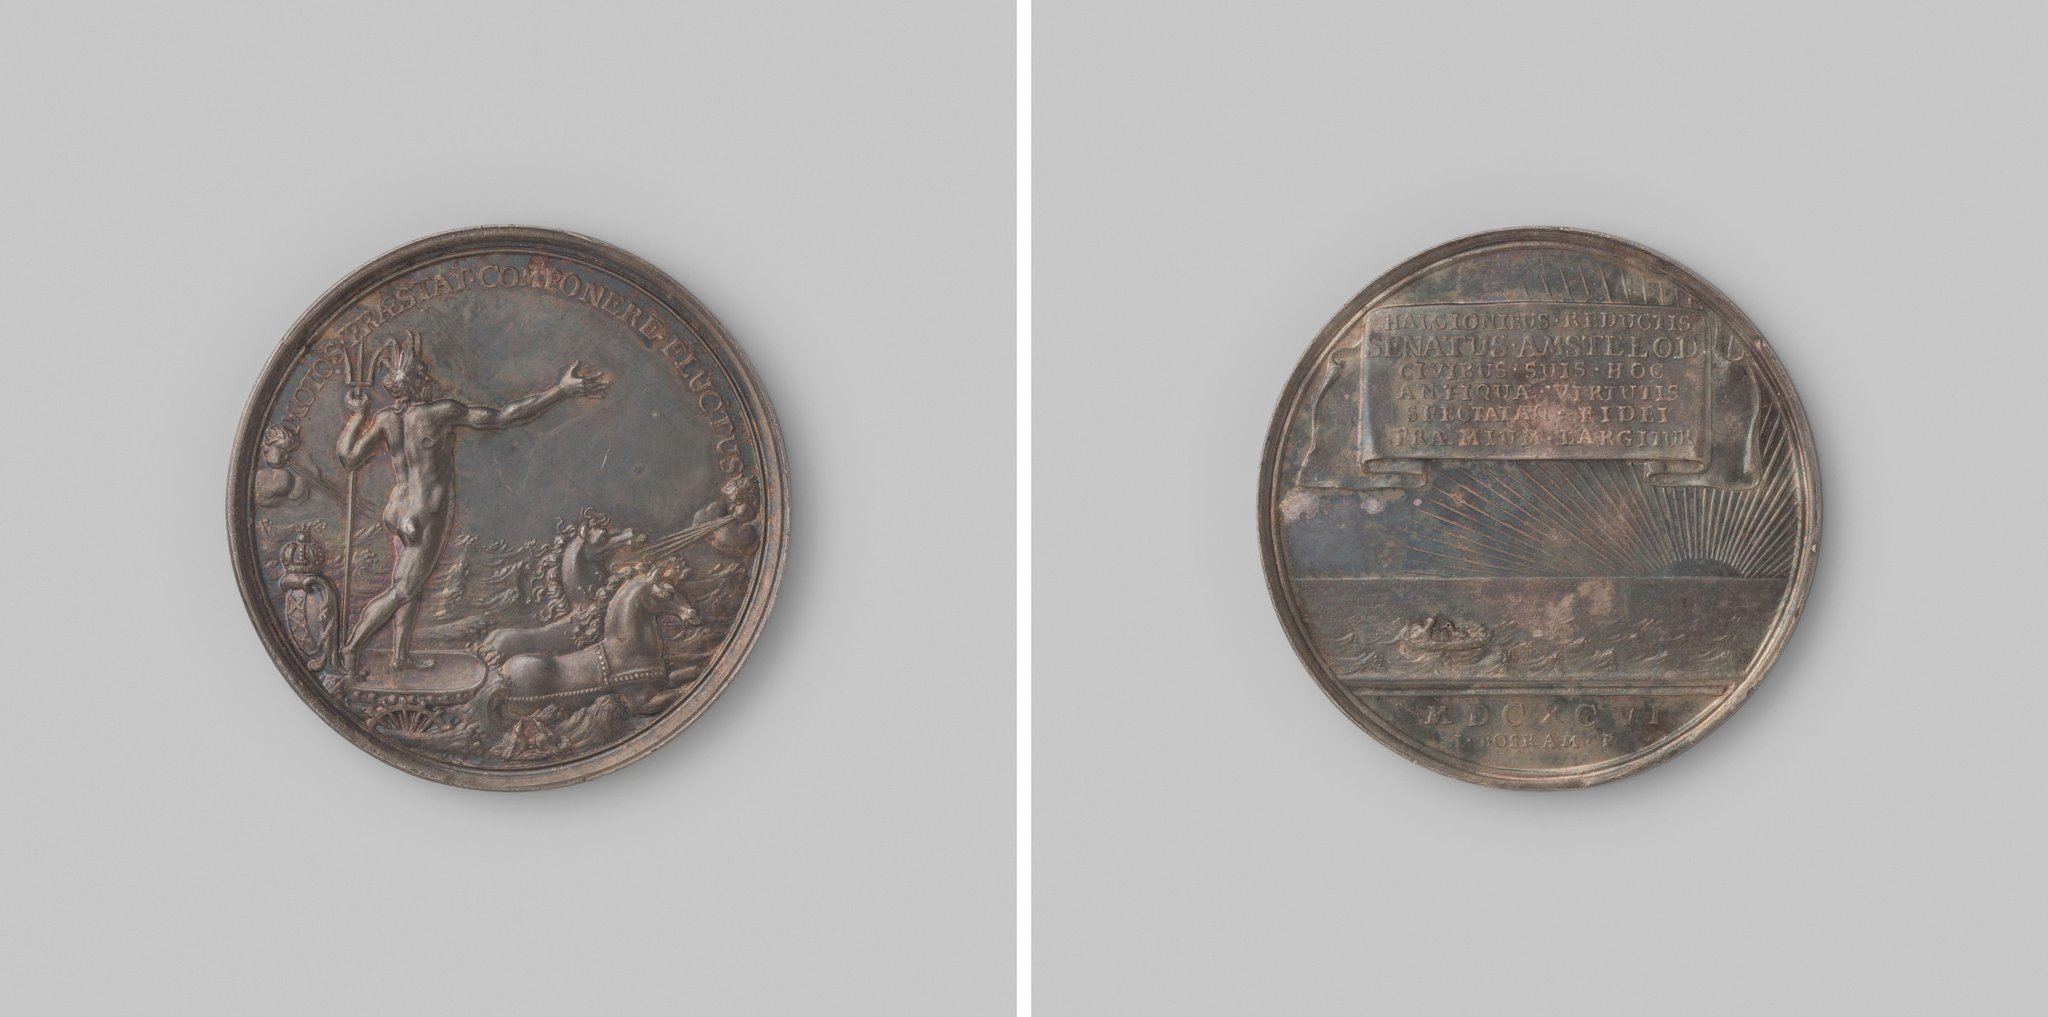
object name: history medal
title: Op de demping van het aansprekersoproer te Amsterdam naar aanleiding van de keur op het begraven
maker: i. roskam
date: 1696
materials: silver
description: Zilveren penning, 3e grootte. Door de magistraat uitgereikt aan de schutters. Voorzijde: Neptunus bestraft de winden staande op zijn wagen met het stadswapen van Amsterdam met keizerskroon. Op de voorgrond twee vogels die uit het nest vallen. Omschrift: MOTOS PRAESTAT COMPONERE FLVCTVS (Beter om de in beroering gebrachte golven te bedaren). Keerzijde: twee vogels in een nest op kalme zee, terwijl de zon in de verte oprijst uit het water. Wimpel met opschrift: HALCYONIBVS REDVCTIS/ SENATVS AMSTELOD(AMENSIS)/ CIVIBVS SVIS HOC/ ANTIQVAE VIRTVTIS/ SPECTATAE Q/ (VE) FIDEI/ PRAEMIVM LARGITVR (Nadat de ijsvogels teruggevoerd zijn heeft de regering van Amsterdam aan hare [gewapende] burgers deze beloning gegeven voor hun oudvaderlijke dapperheid en hun beproefde trouw). Afsnede: MDCXCVI (1696) I. ROSKAM F.(ecit). Variant.